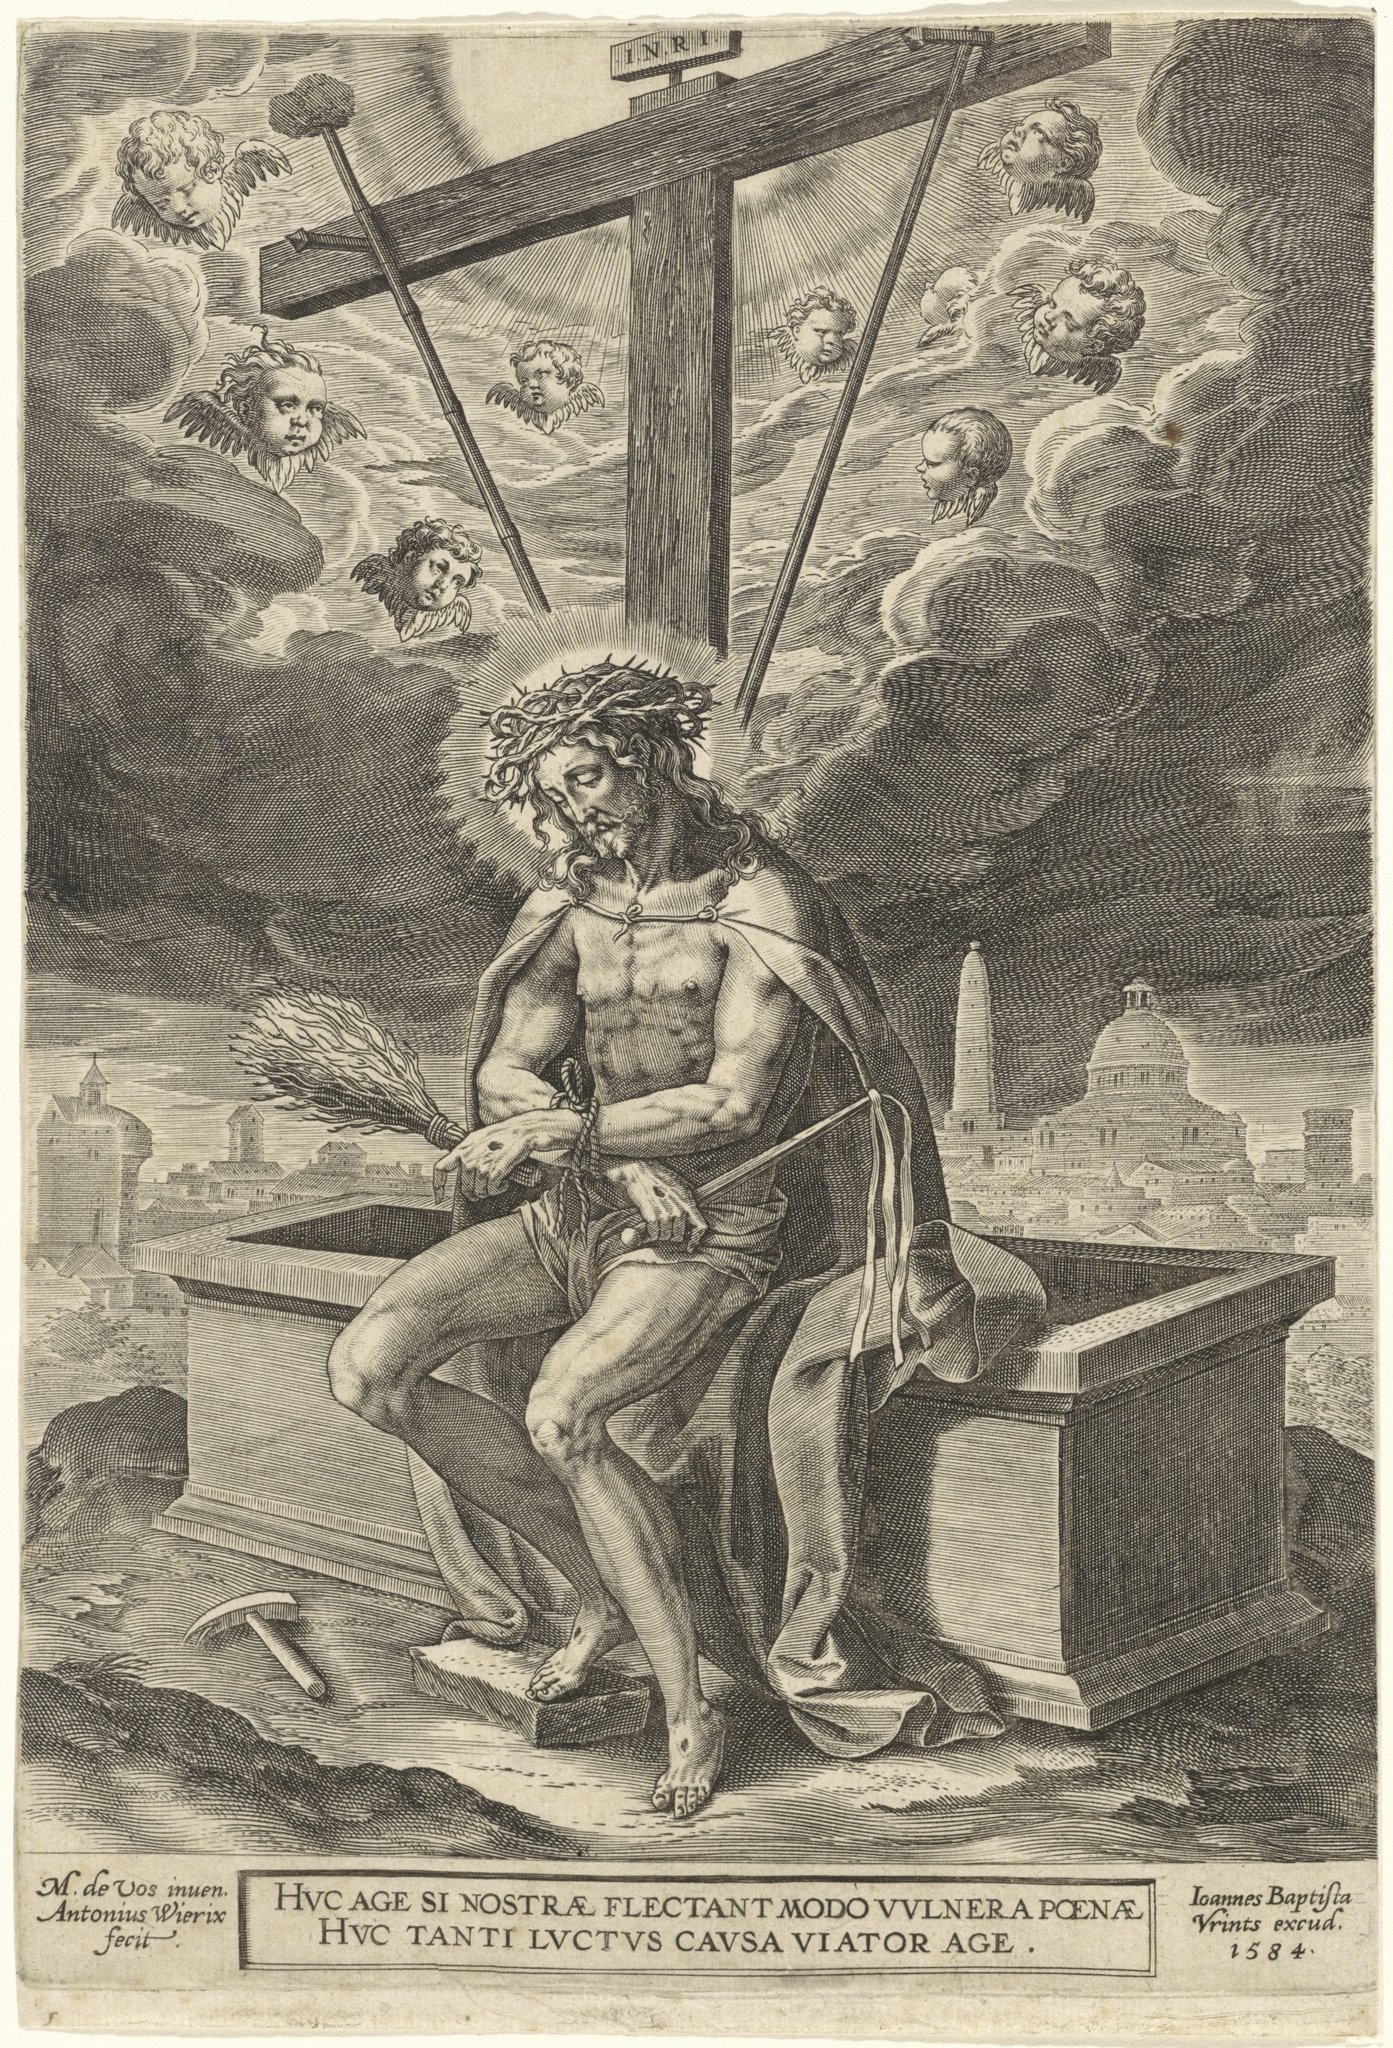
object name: print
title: Christus als man van smarten, bij zijn graf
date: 1584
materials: paper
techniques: engraving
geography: antwerp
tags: man of sorrows, 'imago pietatis', 'erbärmdebild', 'schmerzensmann'; the upright christ showing his wounds, usually bearing the crown of thorns, and accompanied by the instruments of the passion, standing or sitting in his tomb (+ angel(s))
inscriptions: number: ‘5’, collector's mark: Lugt 2228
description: Christus zit met geboeide handen op de rand van zijn tombe. Hij draagt de doornenkroon en houdt gesels in zijn handen. Zijn kruiswonden zijn duidelijk zichtbaar. Achter hem het kruis, omringd door cherubijnen. Op de achtergrond een gezicht op Jeruzalem. In het kader in de marge een tweeregelig onderschrift in het Latijn.